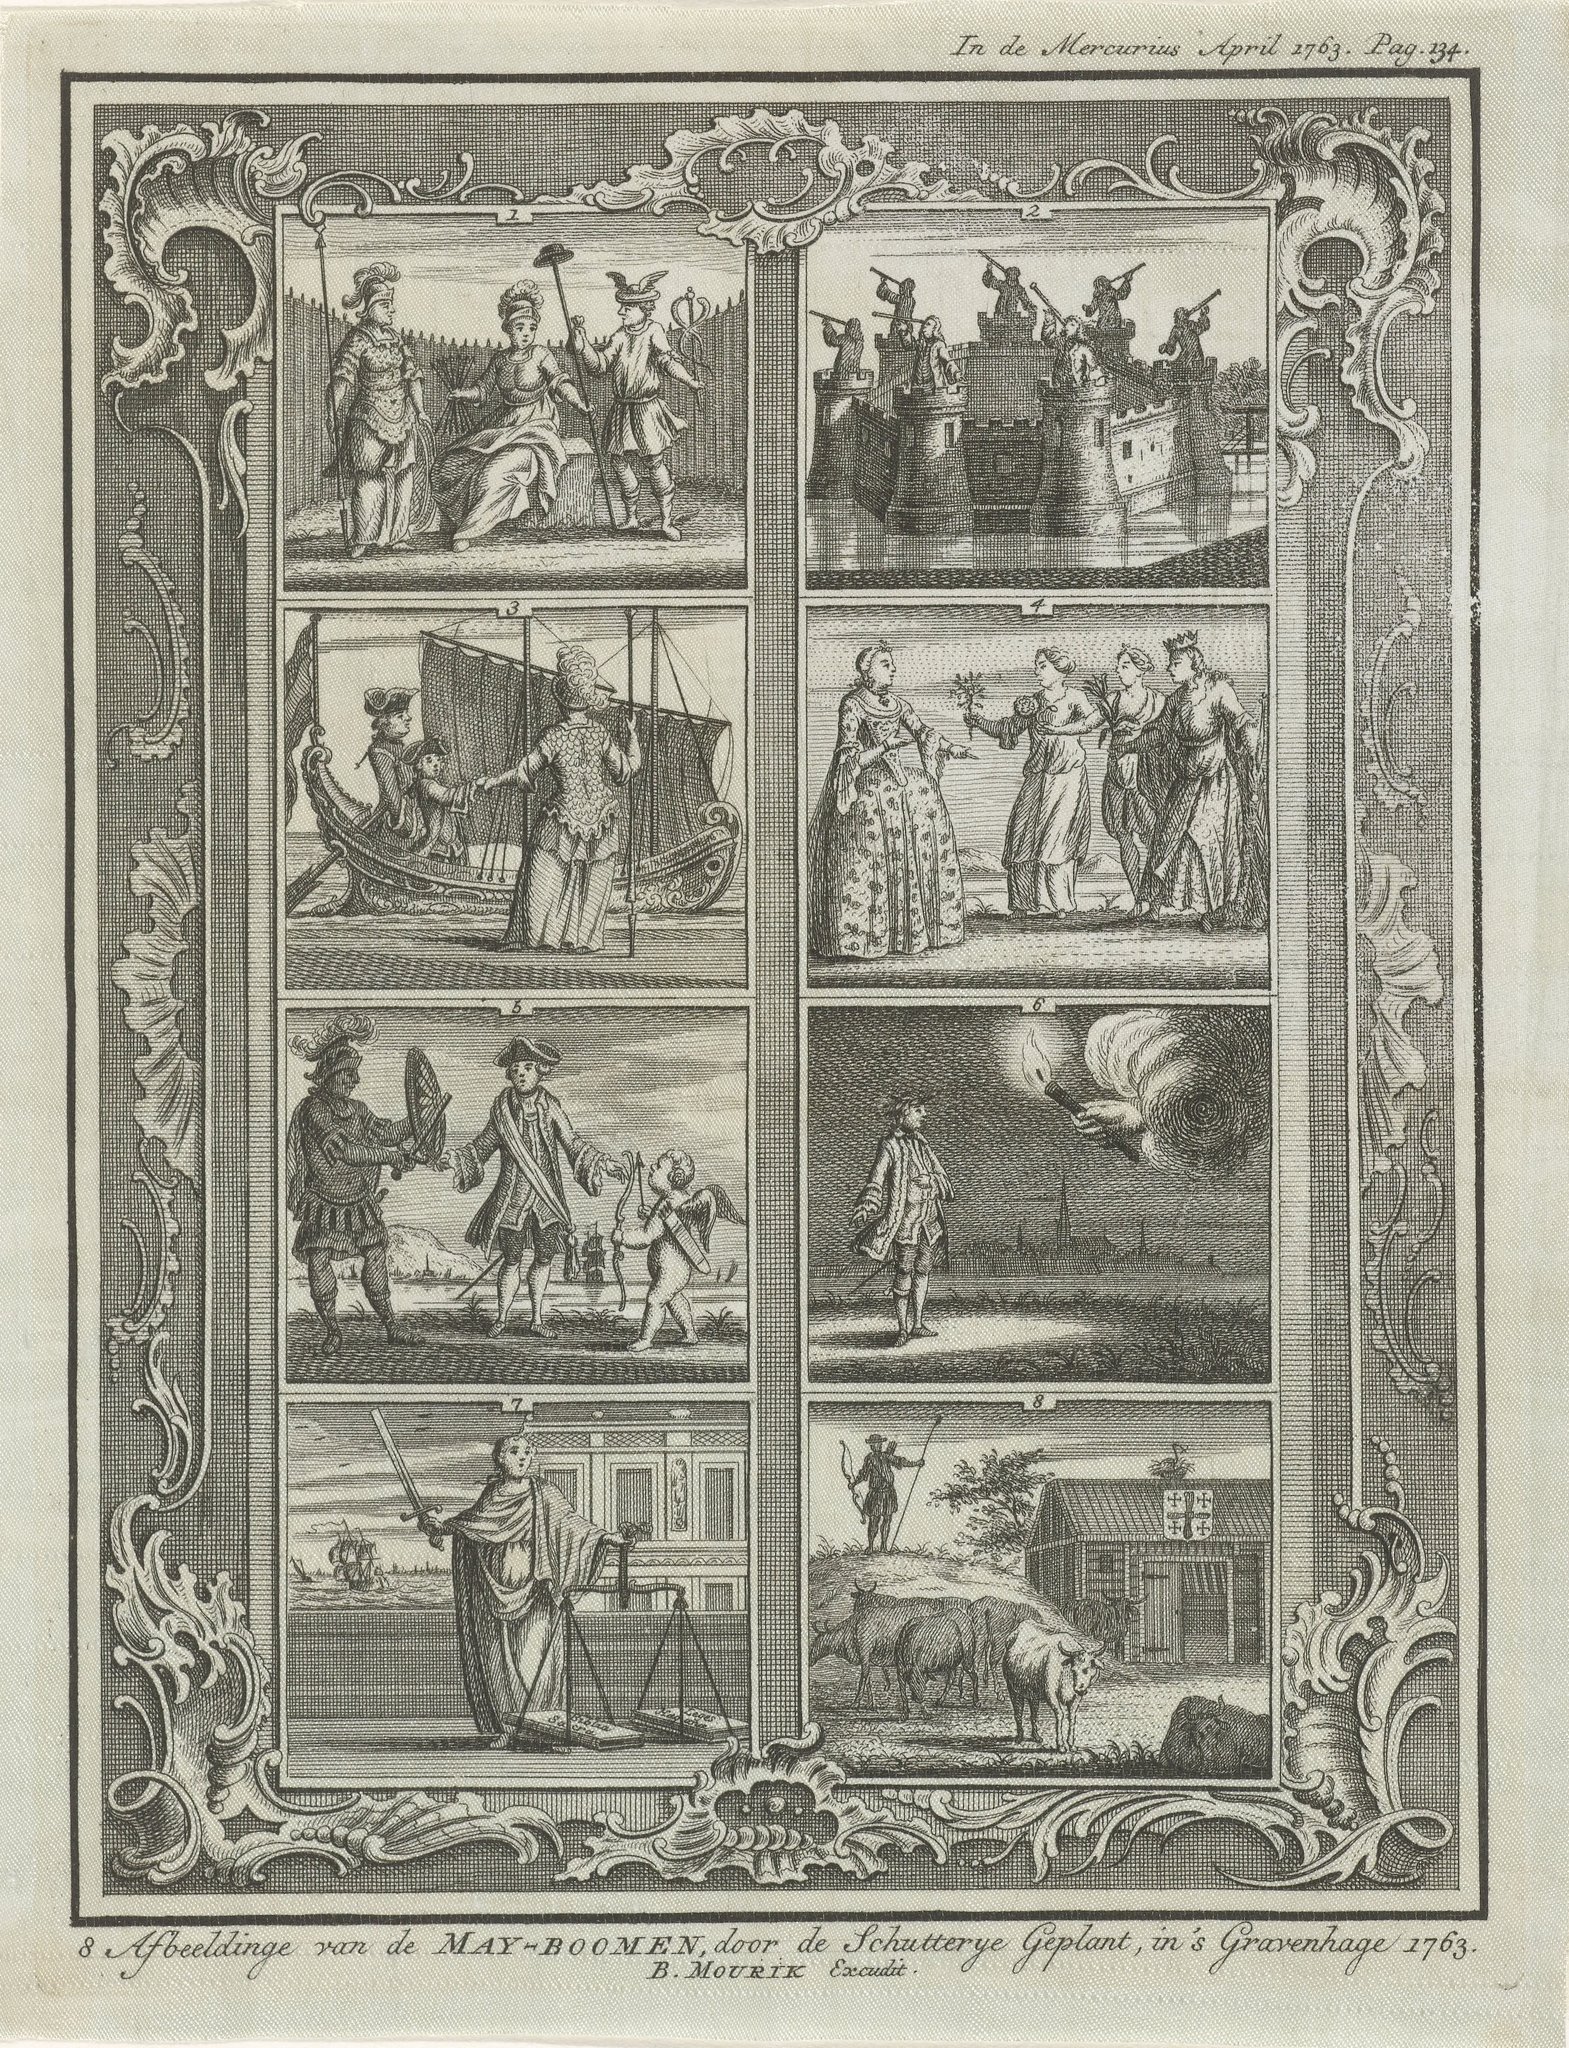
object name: print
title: 8 Afbeeldinge van de May-Boomen, door de Schutterye Geplant, in 's Gravenhage 1763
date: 1763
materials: textile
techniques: engraving, etching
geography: northern netherlands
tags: maypole, the hague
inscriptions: collector's mark: Lugt 2228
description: De acht allegorische voorstellingen of emblemen van de meiboom geplant door de Schutterij van Den Haag in het jaar 1763.